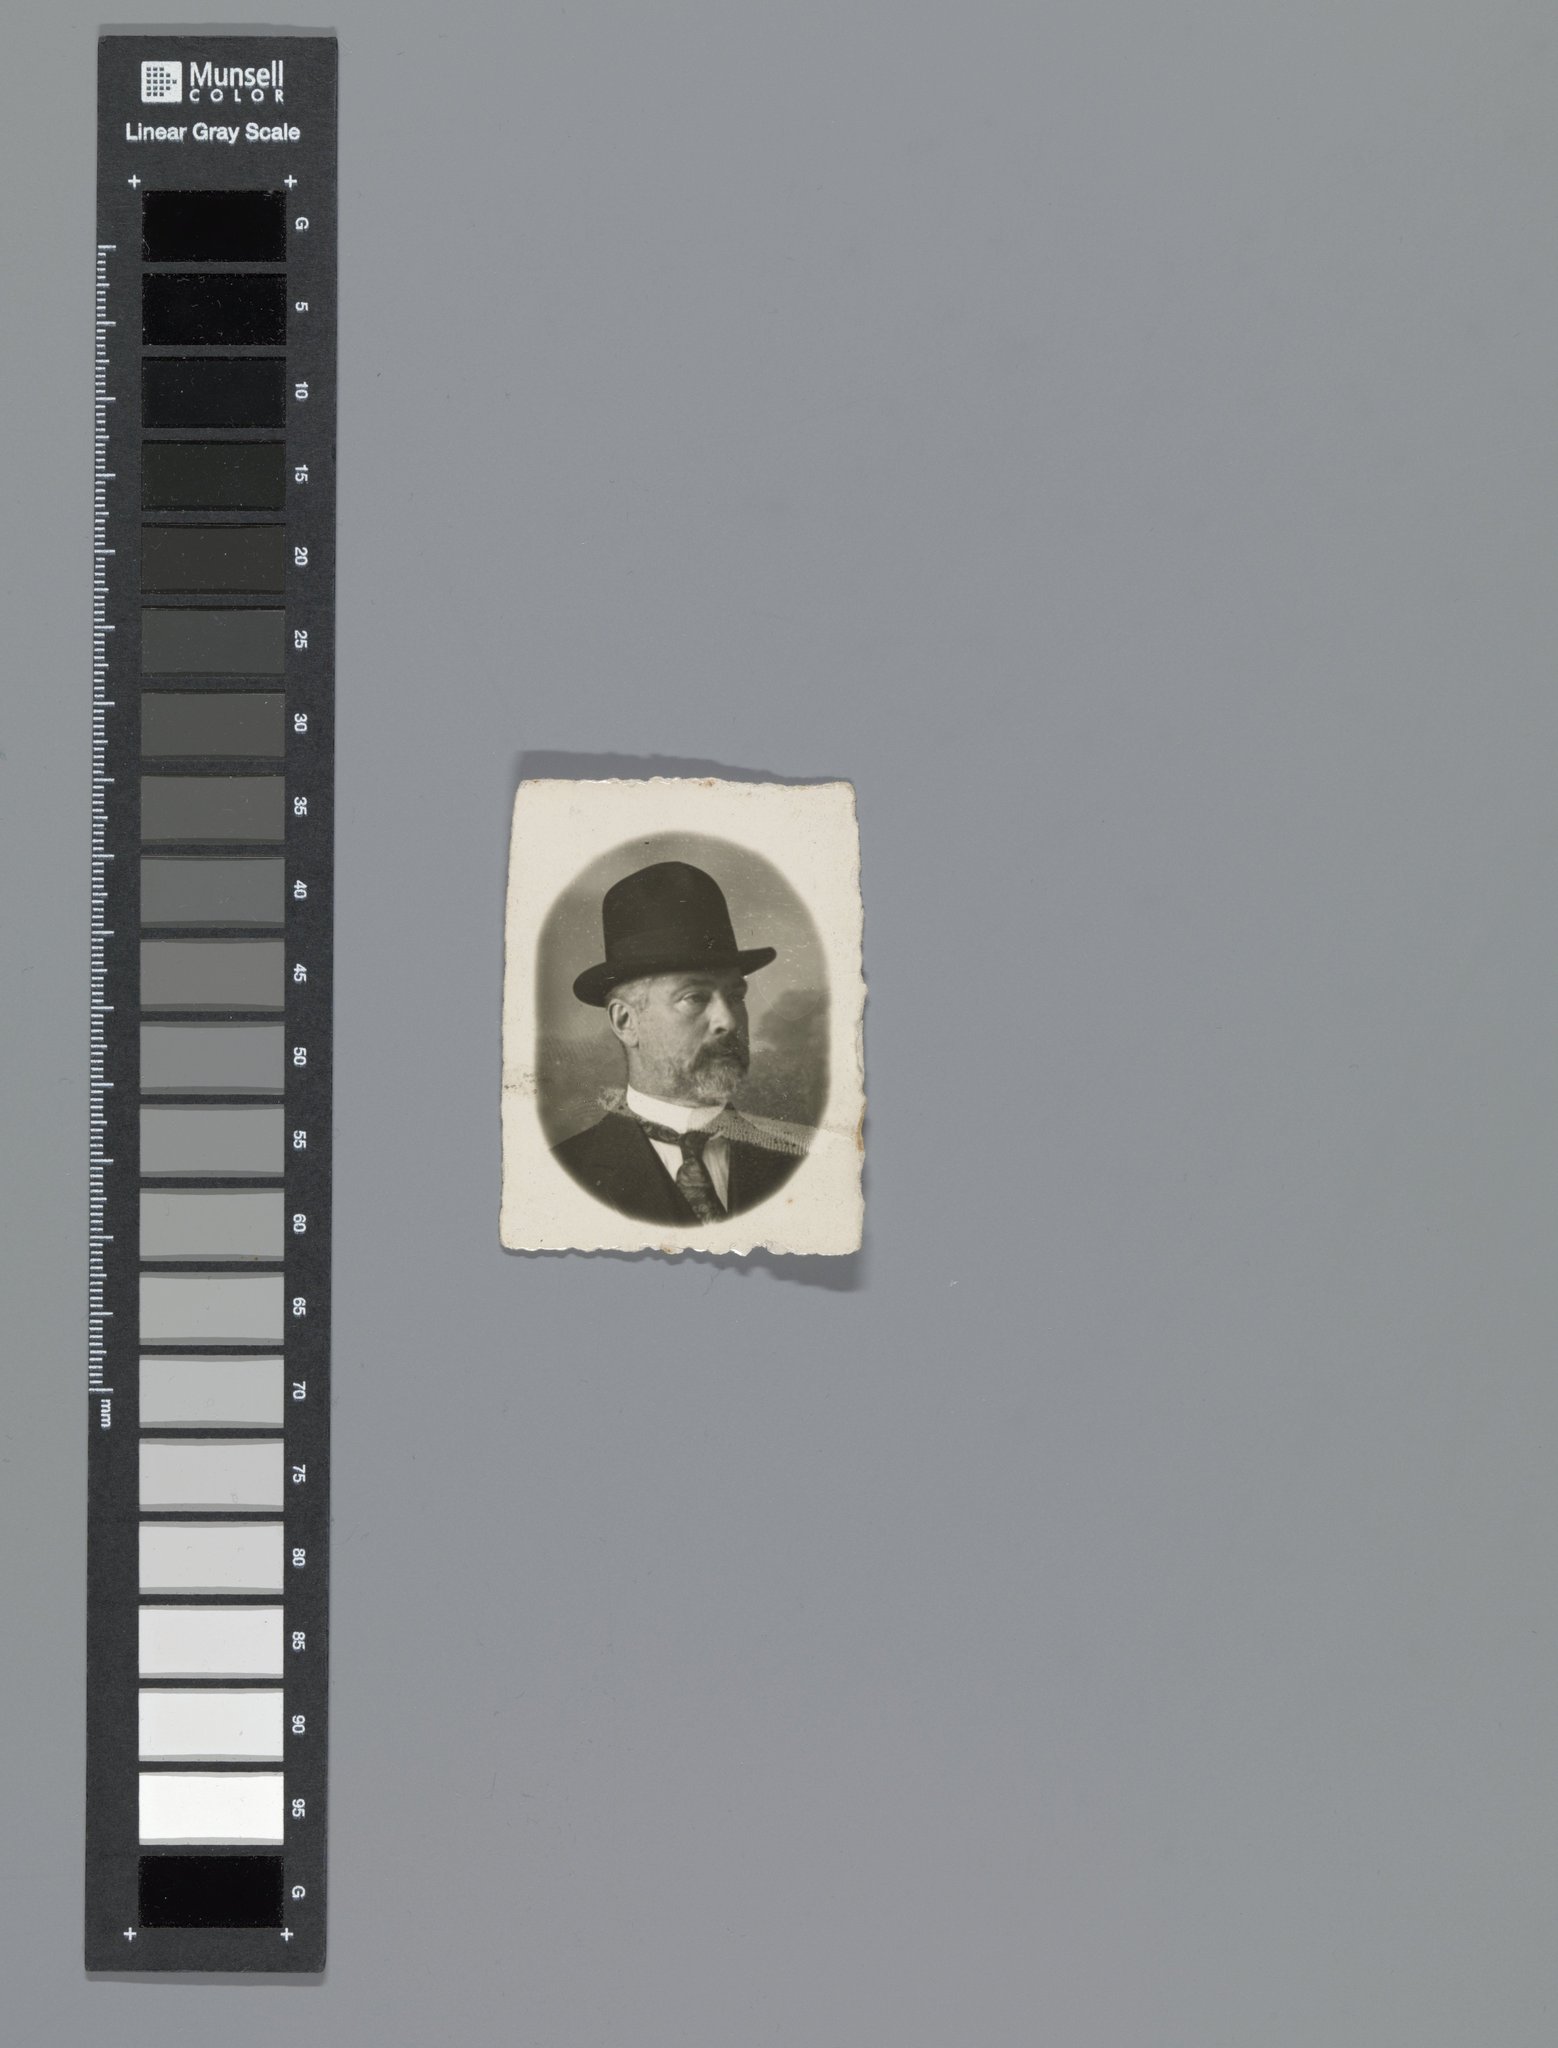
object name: photograph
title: Nieuwenhuis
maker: willem witsen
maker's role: draughtsman, painter, print maker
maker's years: 1860-1923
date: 1860-1915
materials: paper, photographic support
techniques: gelatin silver print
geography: netherlands